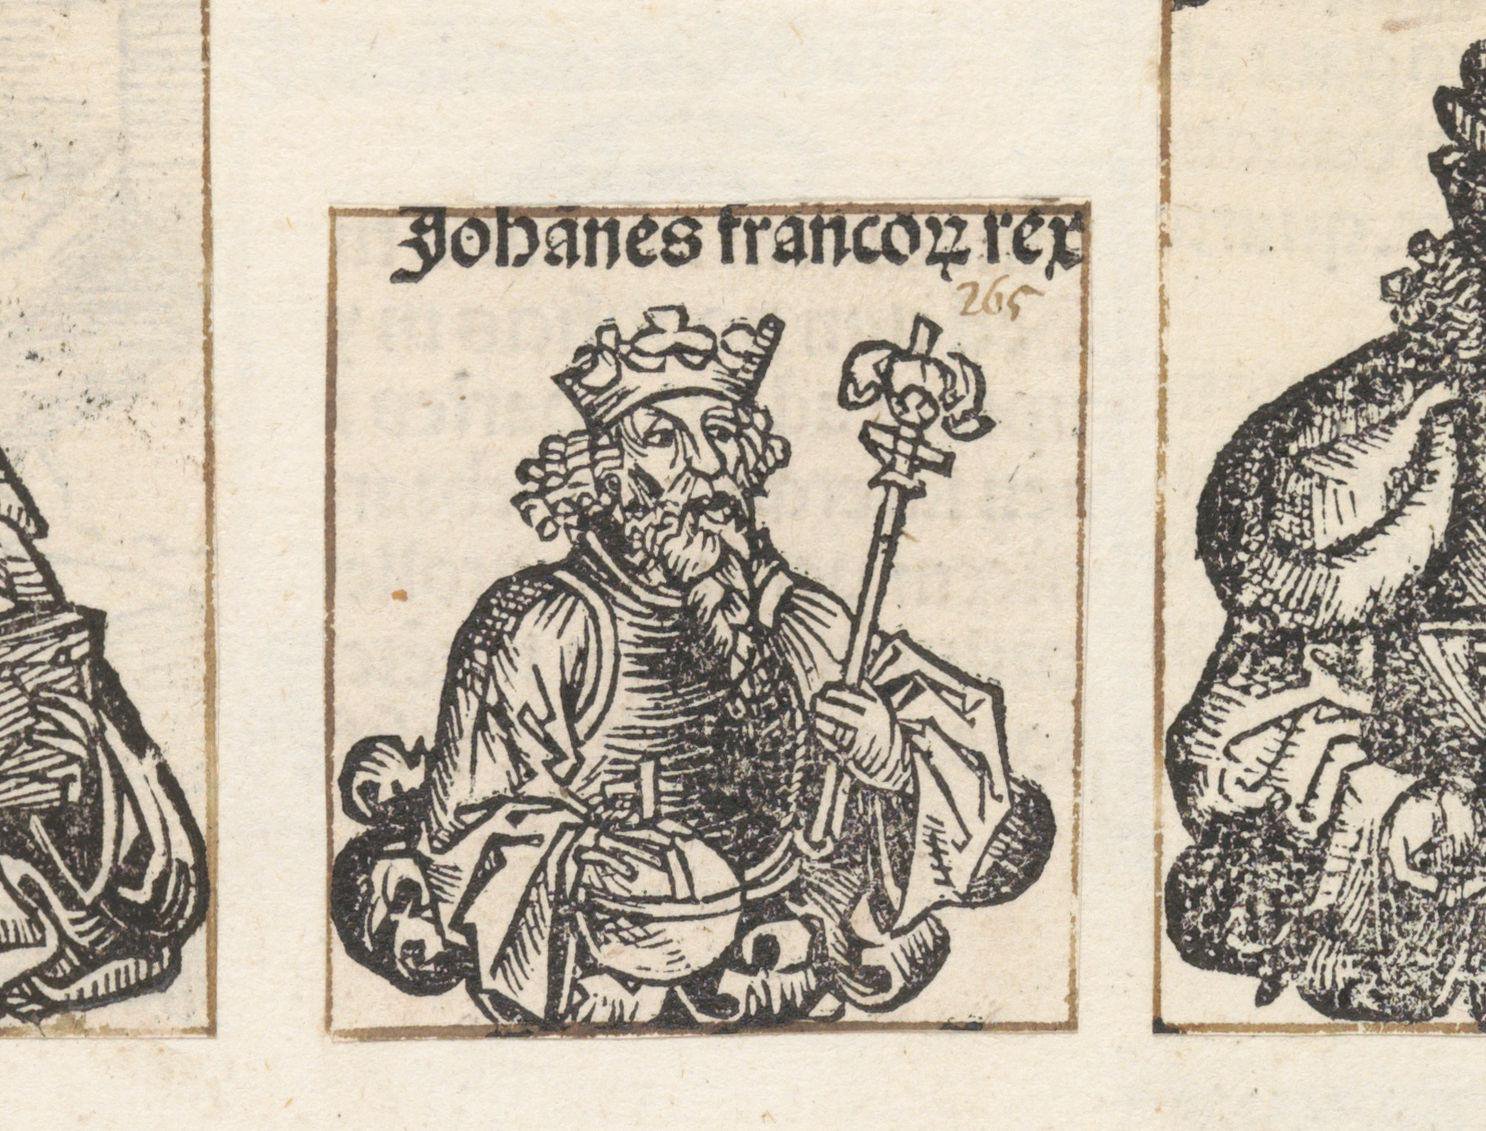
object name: book illustration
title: Liber Chronicarum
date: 1493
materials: paper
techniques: letterpress printing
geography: nuremberg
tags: london, king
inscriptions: inscription: ‘265’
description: De houtsnede wordt herhaaldelijk gebruikt als boekillustratie in de Liber Chronicarum (of Neurenbergkroniek) van Hartmann Schedel, verschenen in het Latijn en Duits in 1493. Zie de Latijnse uitgave, folio 231r.